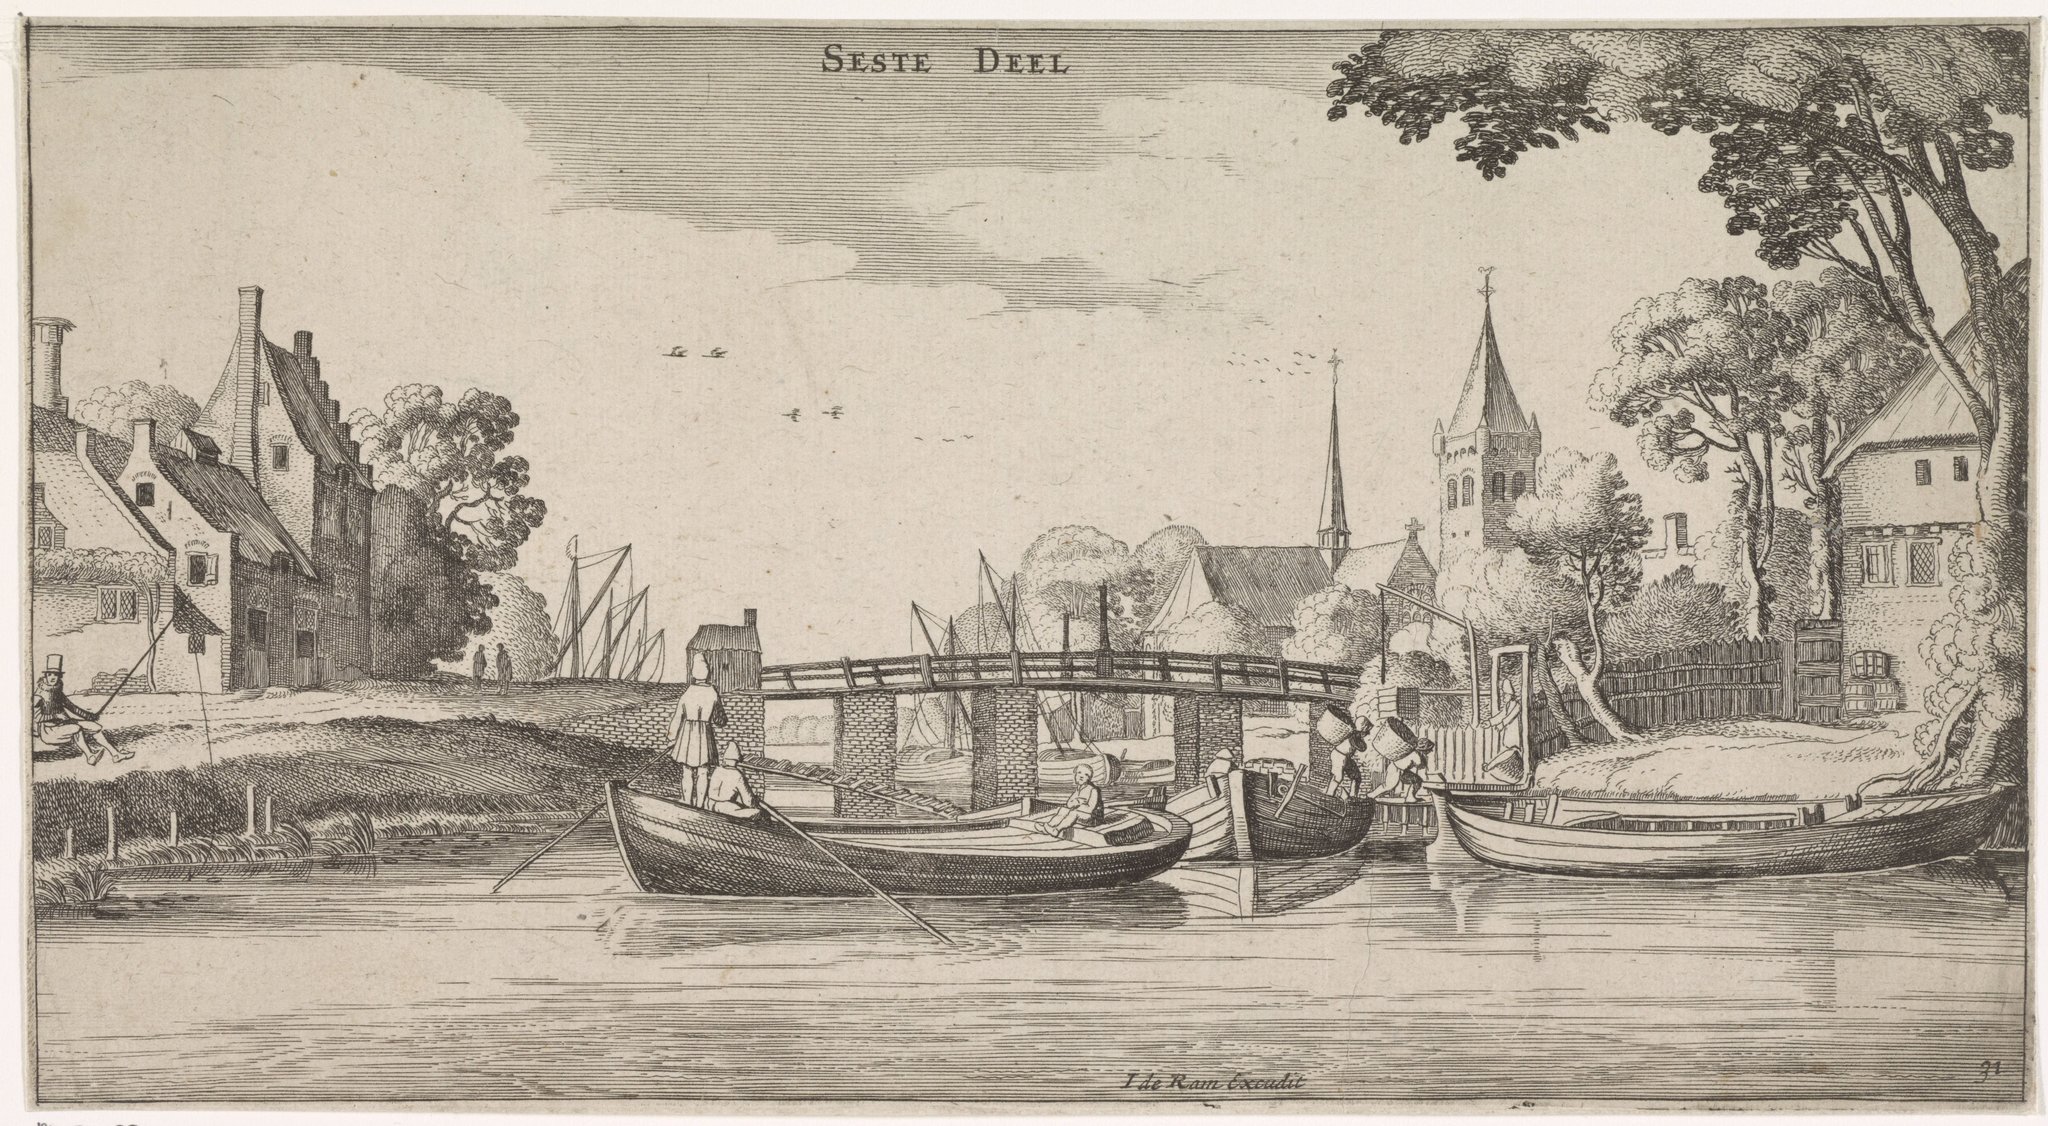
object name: print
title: Boten bij een aanlegsteiger in een dorp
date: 1639-1641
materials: paper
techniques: etching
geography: northern netherlands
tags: city-view in general; 'veduta', river, rowing-boat, canoe, etc., canals, waters (in city), pier, quay, wharf, bridge in city across river, canal, etc., angling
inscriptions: collector's mark: Lugt 2228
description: Boten bij een aanlegsteiger in een dorp. Op de linkeroever van de rivier twee hengelaars en in het midden een brug. 31ste prent van een serie met 36 prenten van landschappen, verdeeld over zes delen.